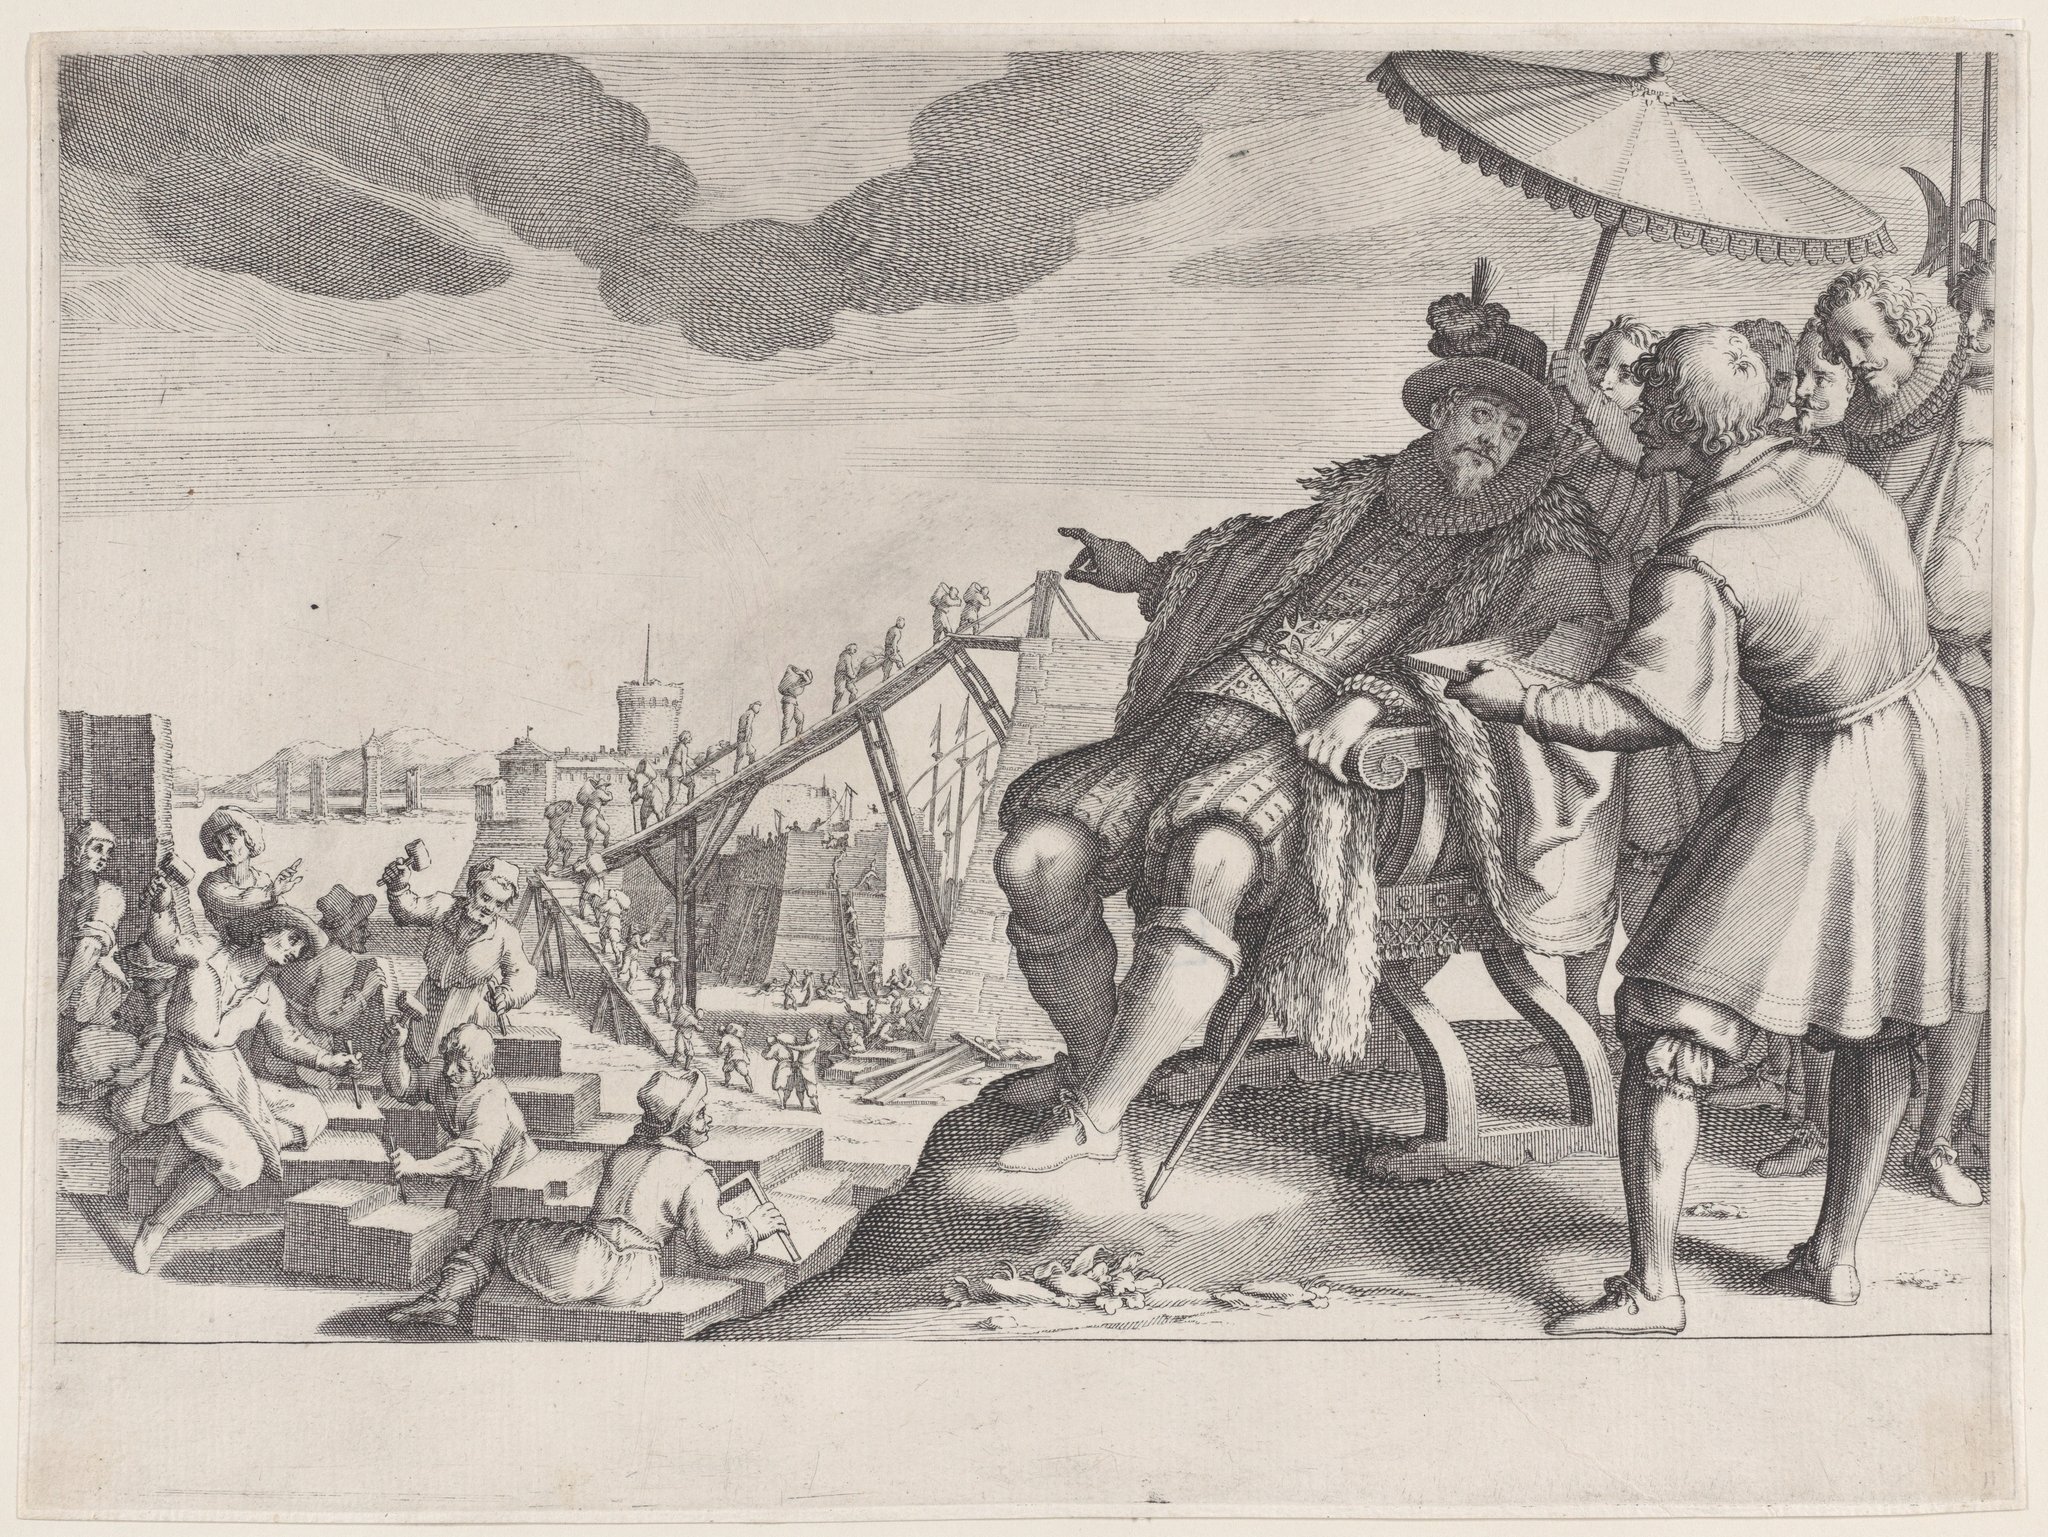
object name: print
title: The Grand Duke fortifies the Port of Livourne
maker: jacques callot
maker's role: artist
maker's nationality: french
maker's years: 1592-1635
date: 1601-1633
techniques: engraving